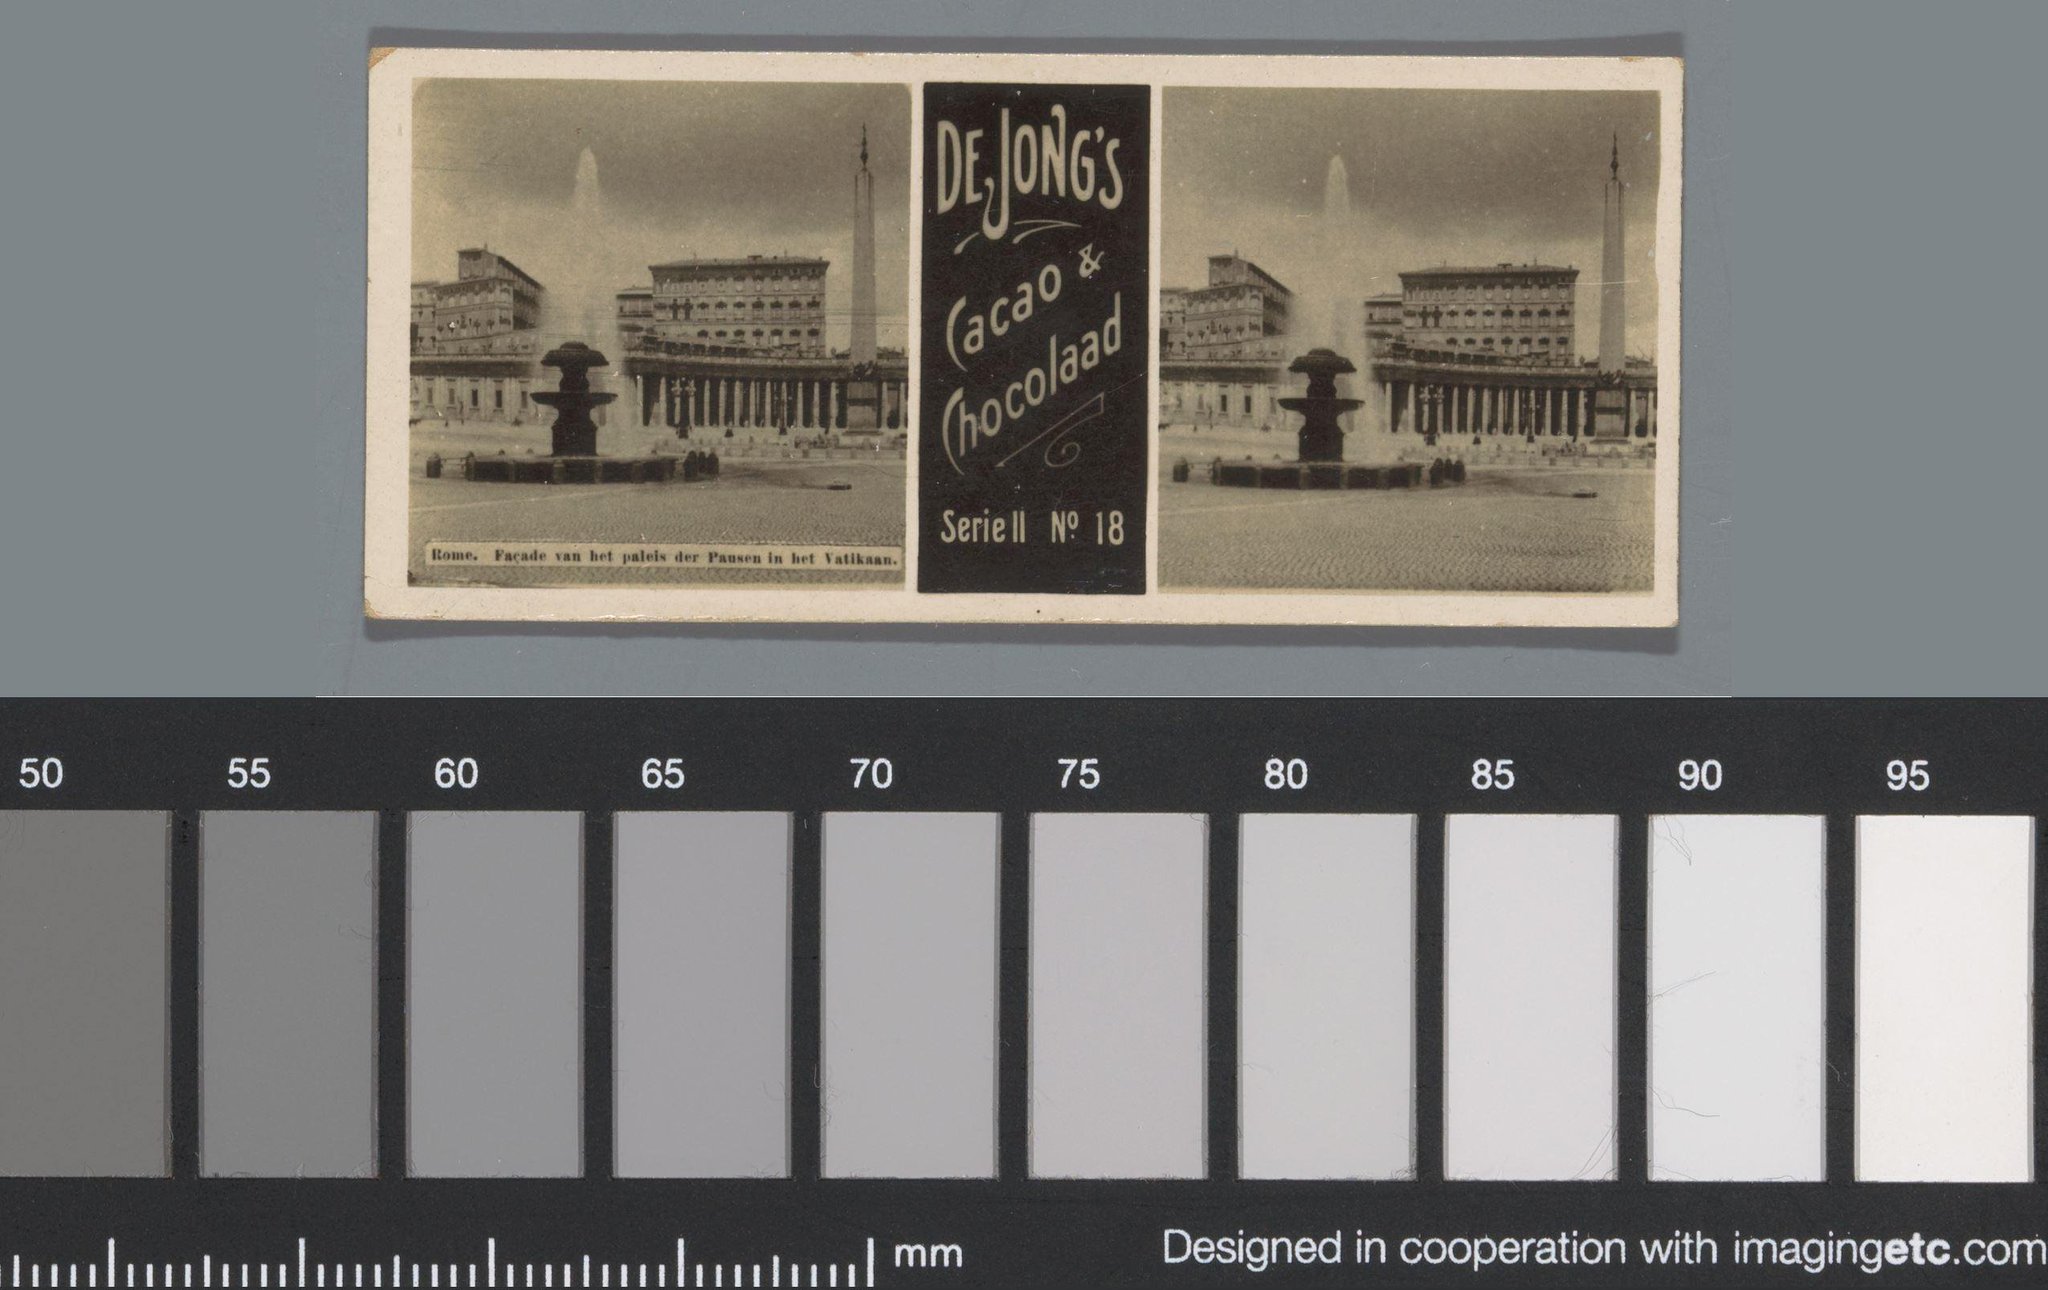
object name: stereograph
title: Exterieur van het Apostolisch Paleis te Vaticaanstad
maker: Anonymous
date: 1900-1910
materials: cardboard, photographic support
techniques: gelatin silver print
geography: vatican city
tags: palace, façade (of house or building)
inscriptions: inscription: ‘De Jong's Cacao & Chocolaad’, number: ‘Serie II No. 18’